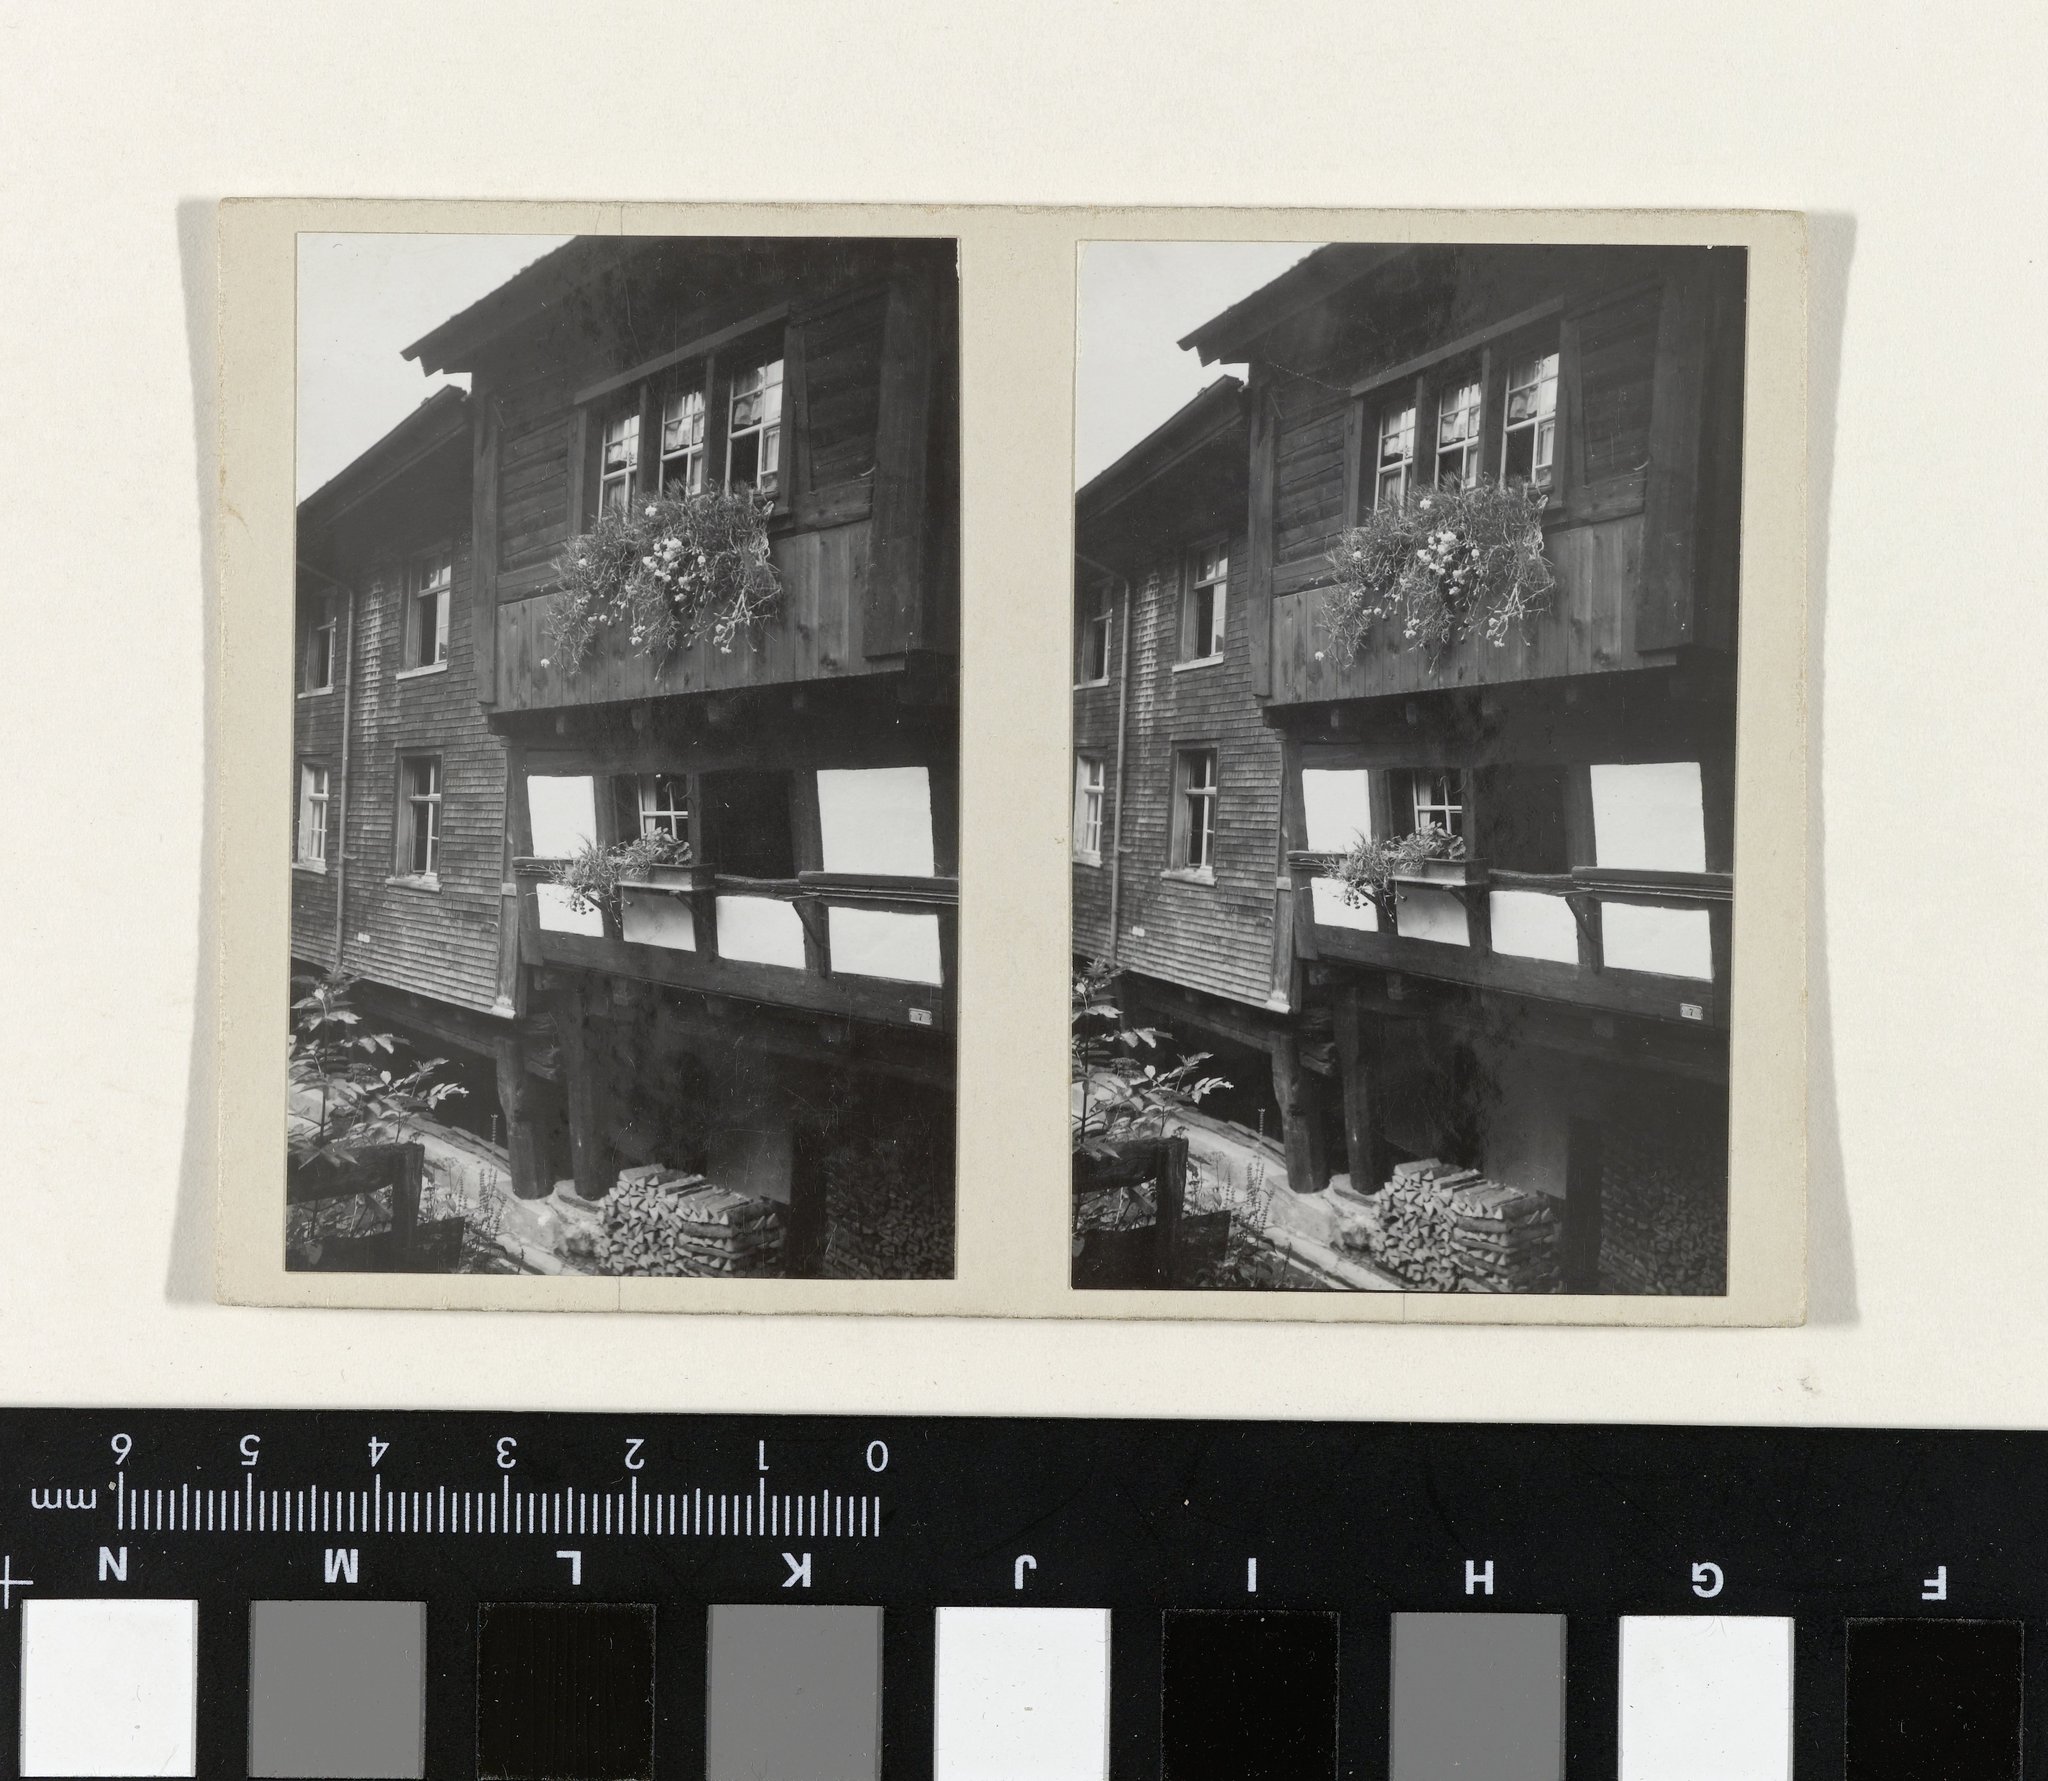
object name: stereograph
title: Woning op palen met bloembakken aan de buitenzijde van het raam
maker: geldolph adriaan kessler (dolph)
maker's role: fotograaf, industrieel, voetballer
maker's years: 1884-1945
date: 1920-1945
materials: paper, photographic support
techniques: collodion silver print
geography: netherlands